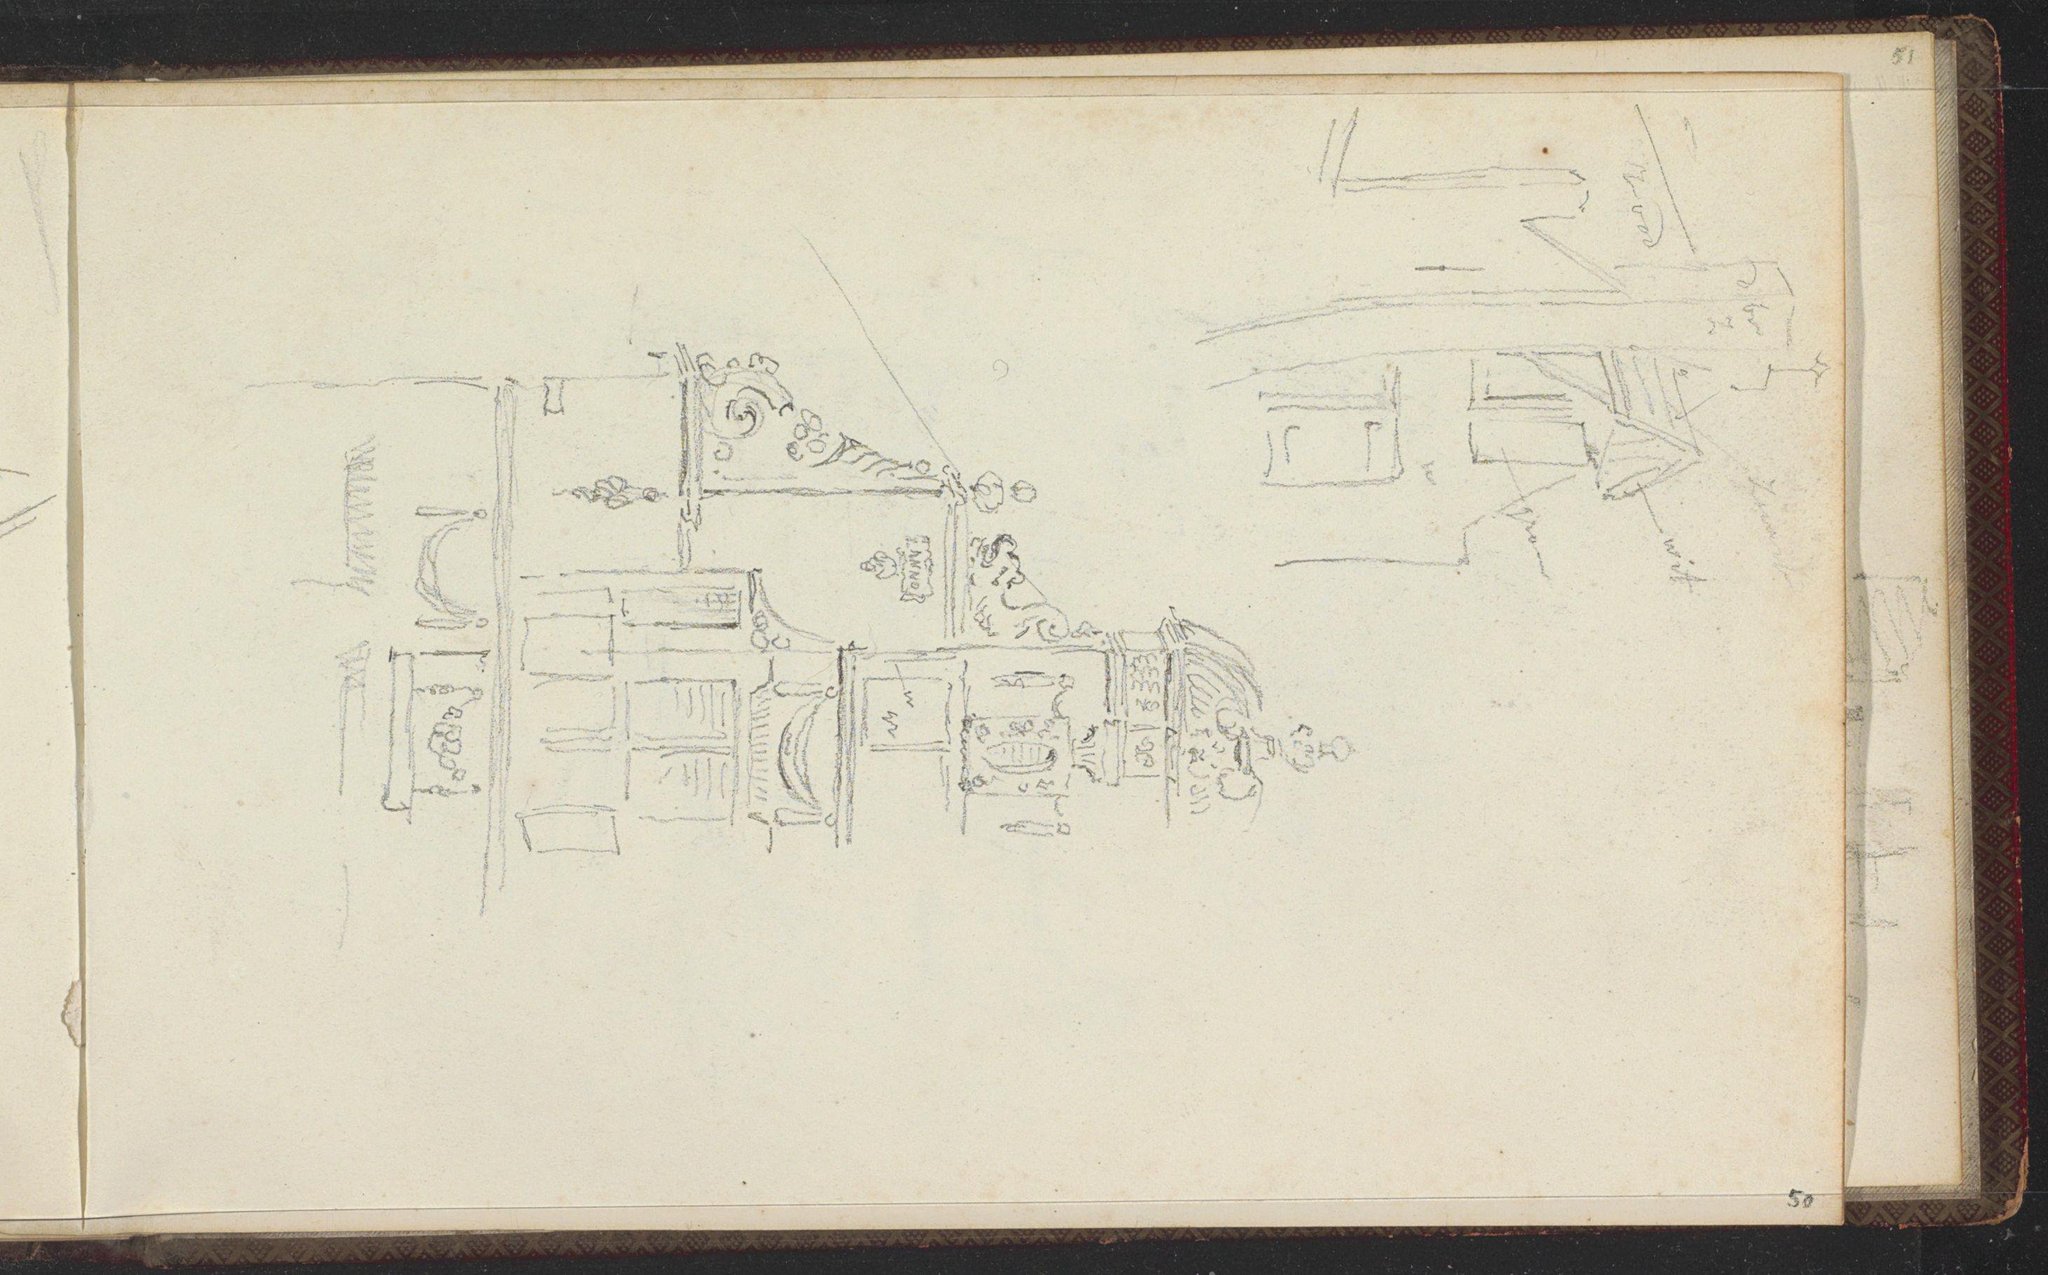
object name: sketchbook leaf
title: Architectuurstudies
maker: adrianus eversen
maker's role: draughtsman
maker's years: 1818-1897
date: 1828-1897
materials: paper, pencil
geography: netherlands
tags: urban housing, decorated gable, architecture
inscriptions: kleurnotitie, handgeschreven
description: Architectuurstudies. Boven een studie van een gebouw. Onder een studie van een gebouw met een verhoogde halsgevel. Blad 50 recto uit een schetsboek met 52 bladen vervaardigd in de omgeving van Kampen, Hattem, Hoorn en Zwolle.